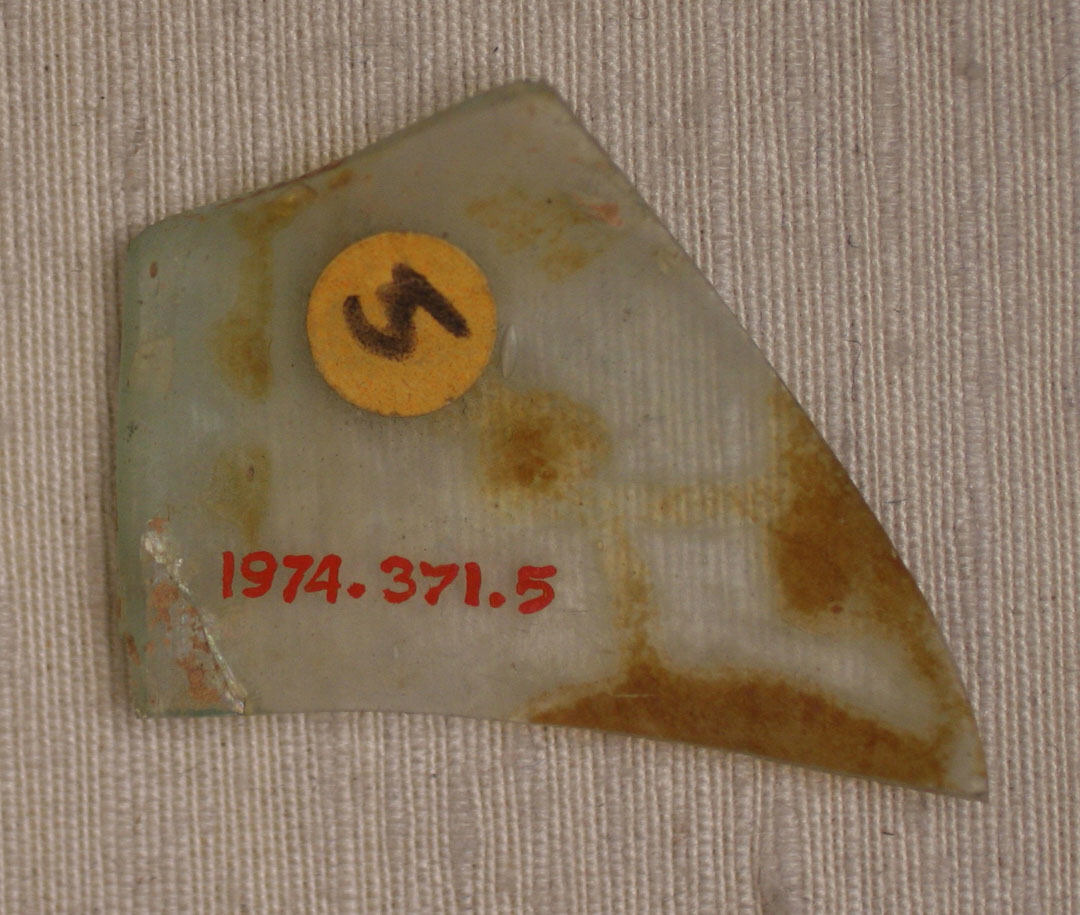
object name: fragment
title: Glass Fragment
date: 801-900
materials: glass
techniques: luster painting, stain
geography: egypt or iraq